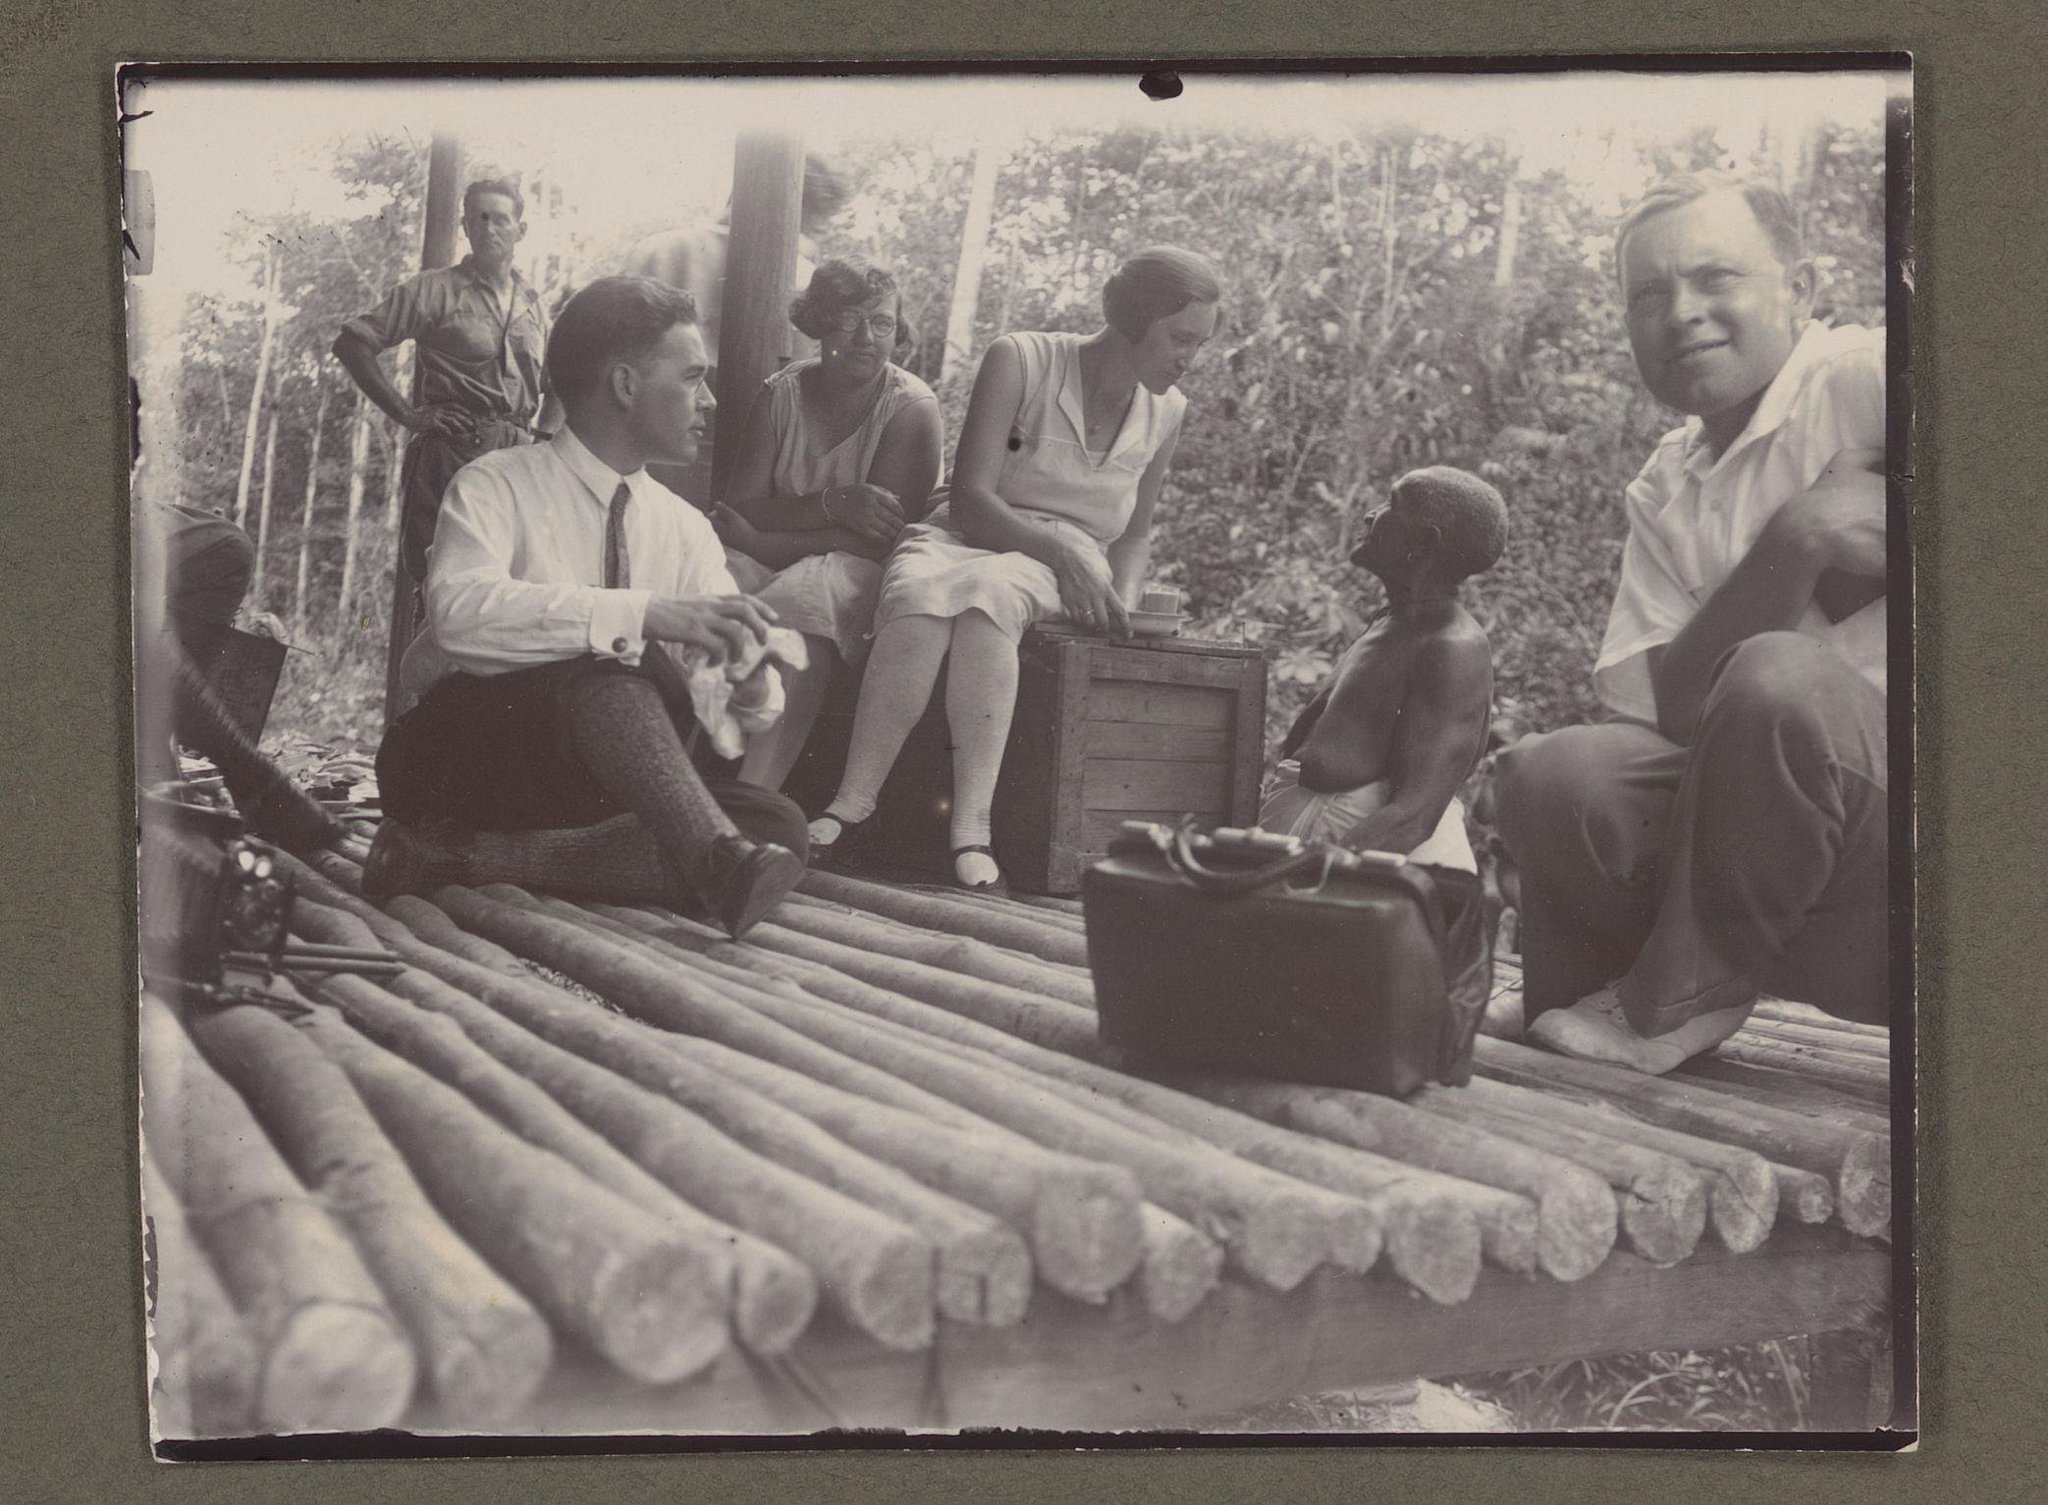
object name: photograph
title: Bezoek aan een dorp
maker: Anonymous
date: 1925-1927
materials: photographic support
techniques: photography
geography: suriname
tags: jetten, familie, moengo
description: Bezoek aan een inlands dorp door een groep Nederlanders waaronder het echtpaar Jetten. Foto op een bladzijde van een los albumblad waarvan een hoek met twee foto's is uitgescheurd. Onderdeel van het ensemble met foto's van de familie van ingenieur Jetten in de mijnbouwstad Moengo in Suriname.